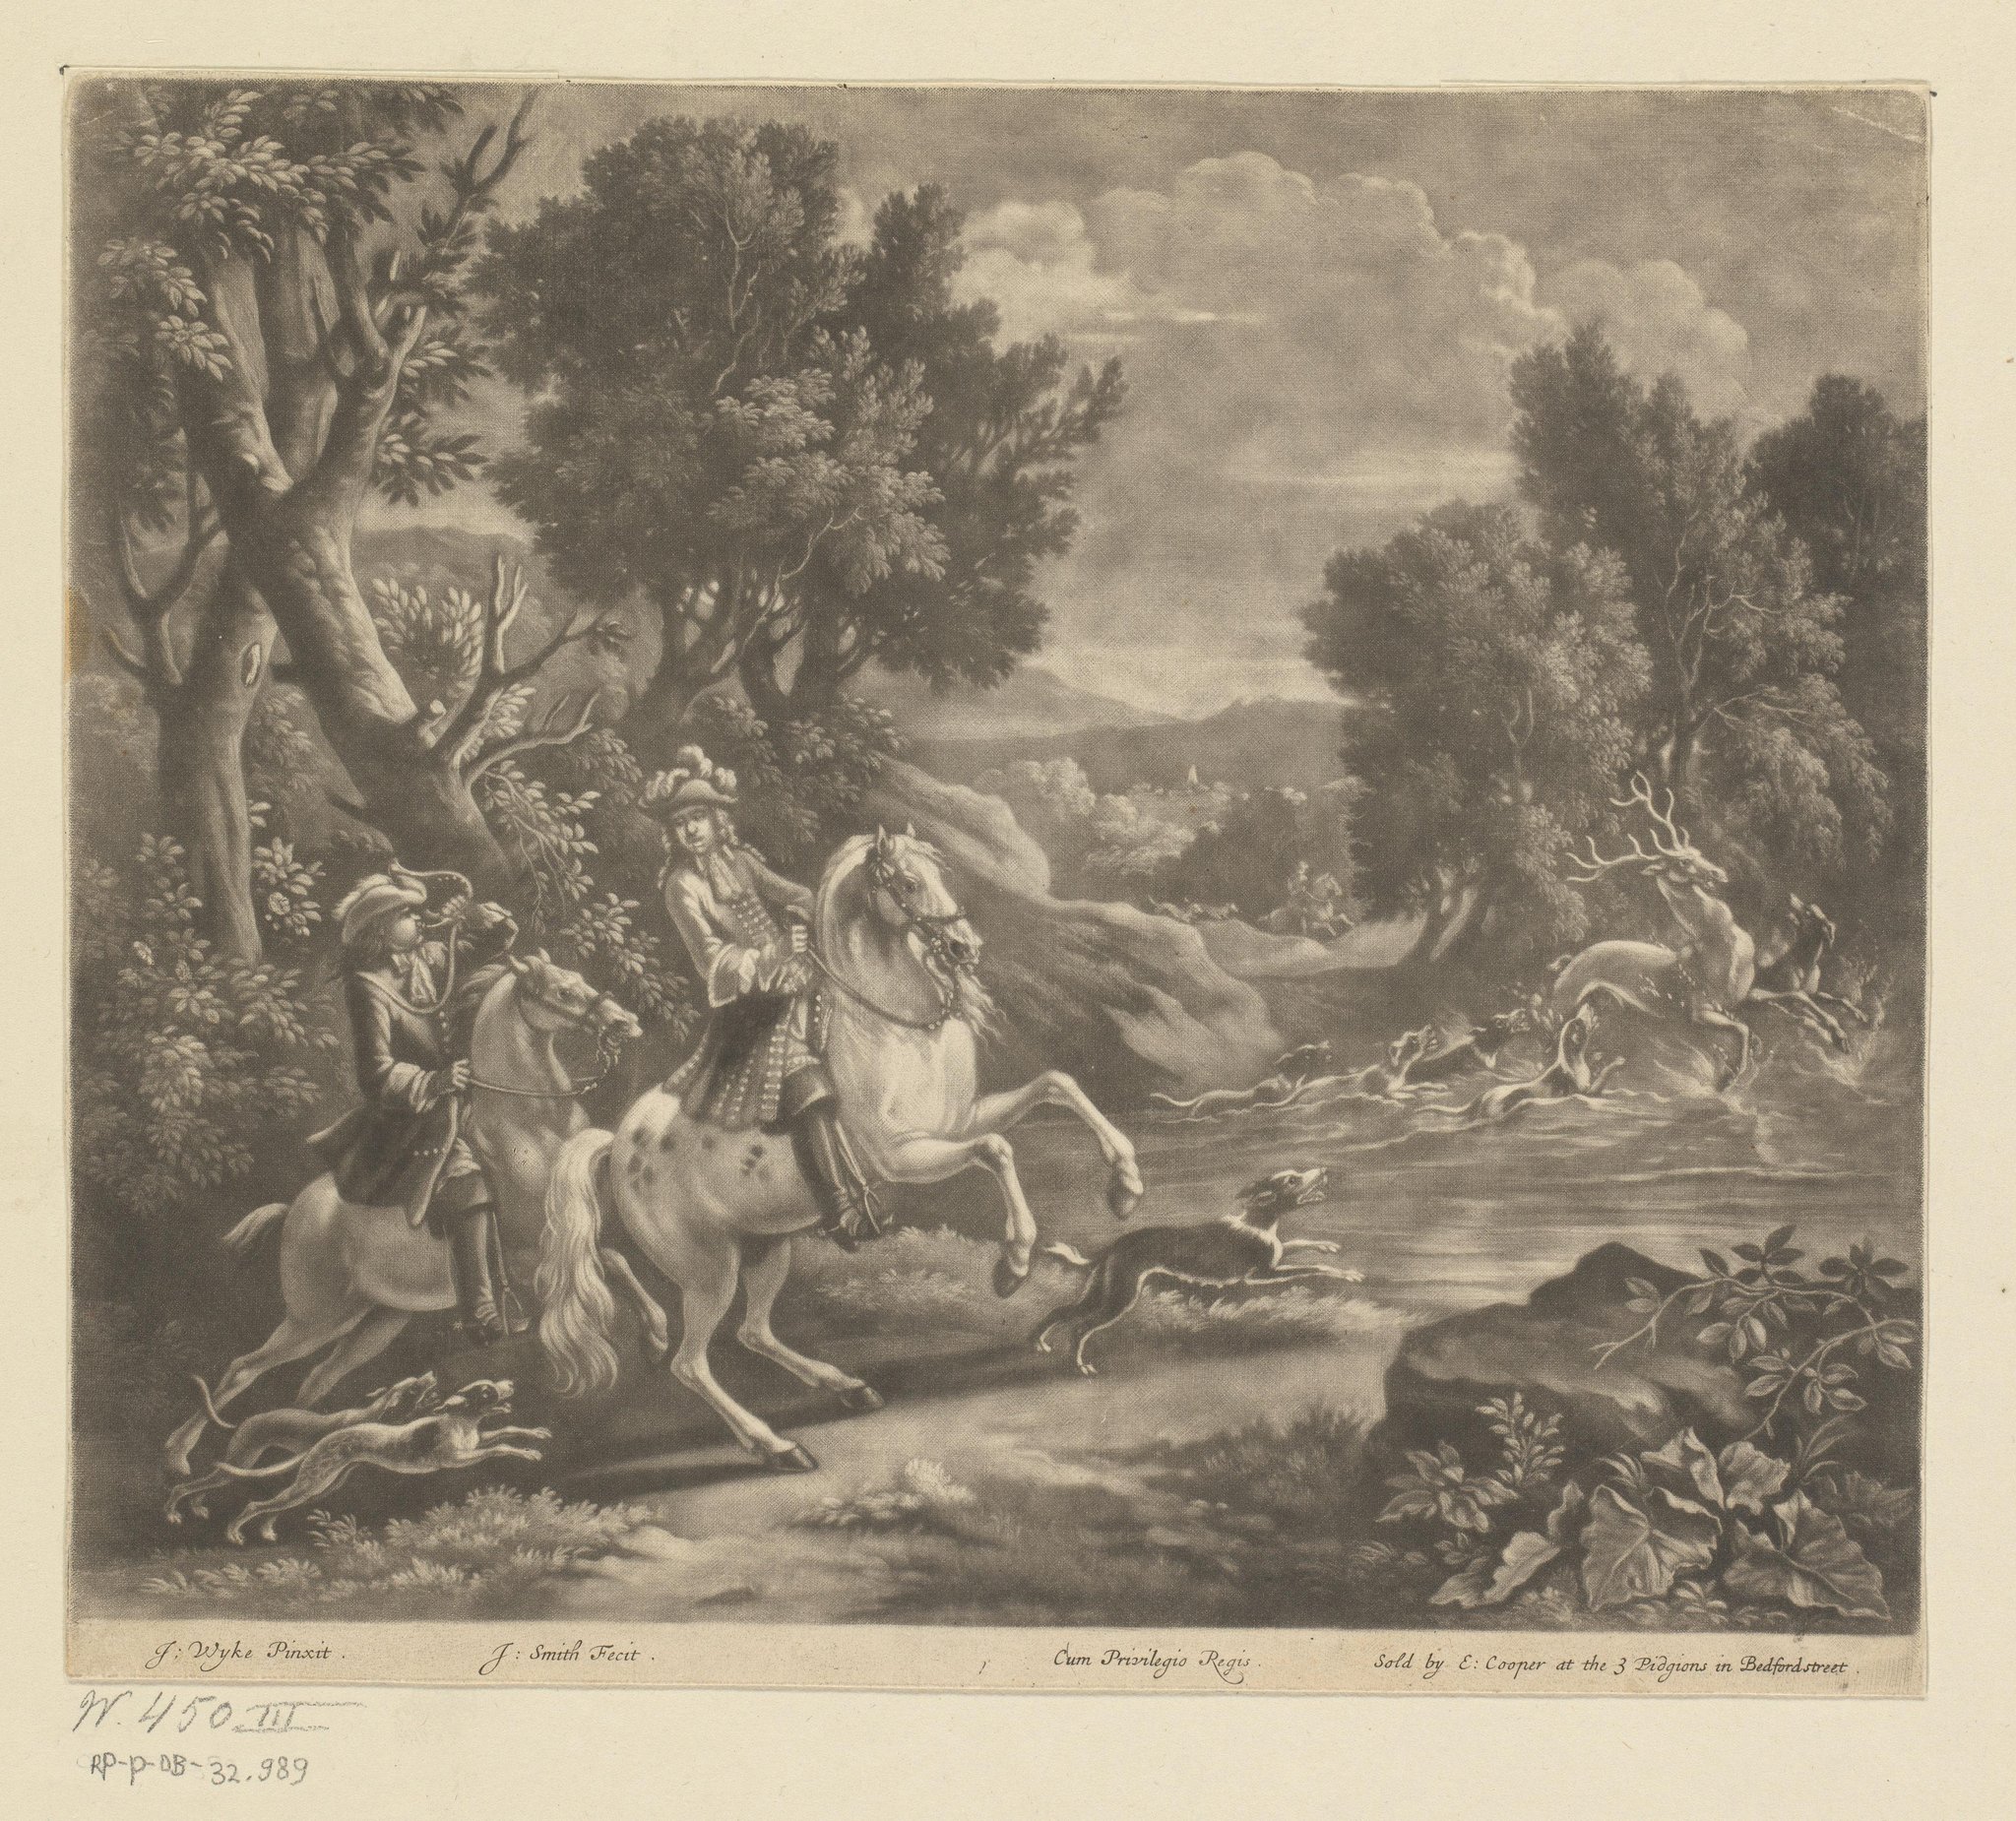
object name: print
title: Hertenjacht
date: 1686-1725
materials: paper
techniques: mezzotint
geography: london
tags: stag-hunting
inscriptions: collector's mark: Lugt 240